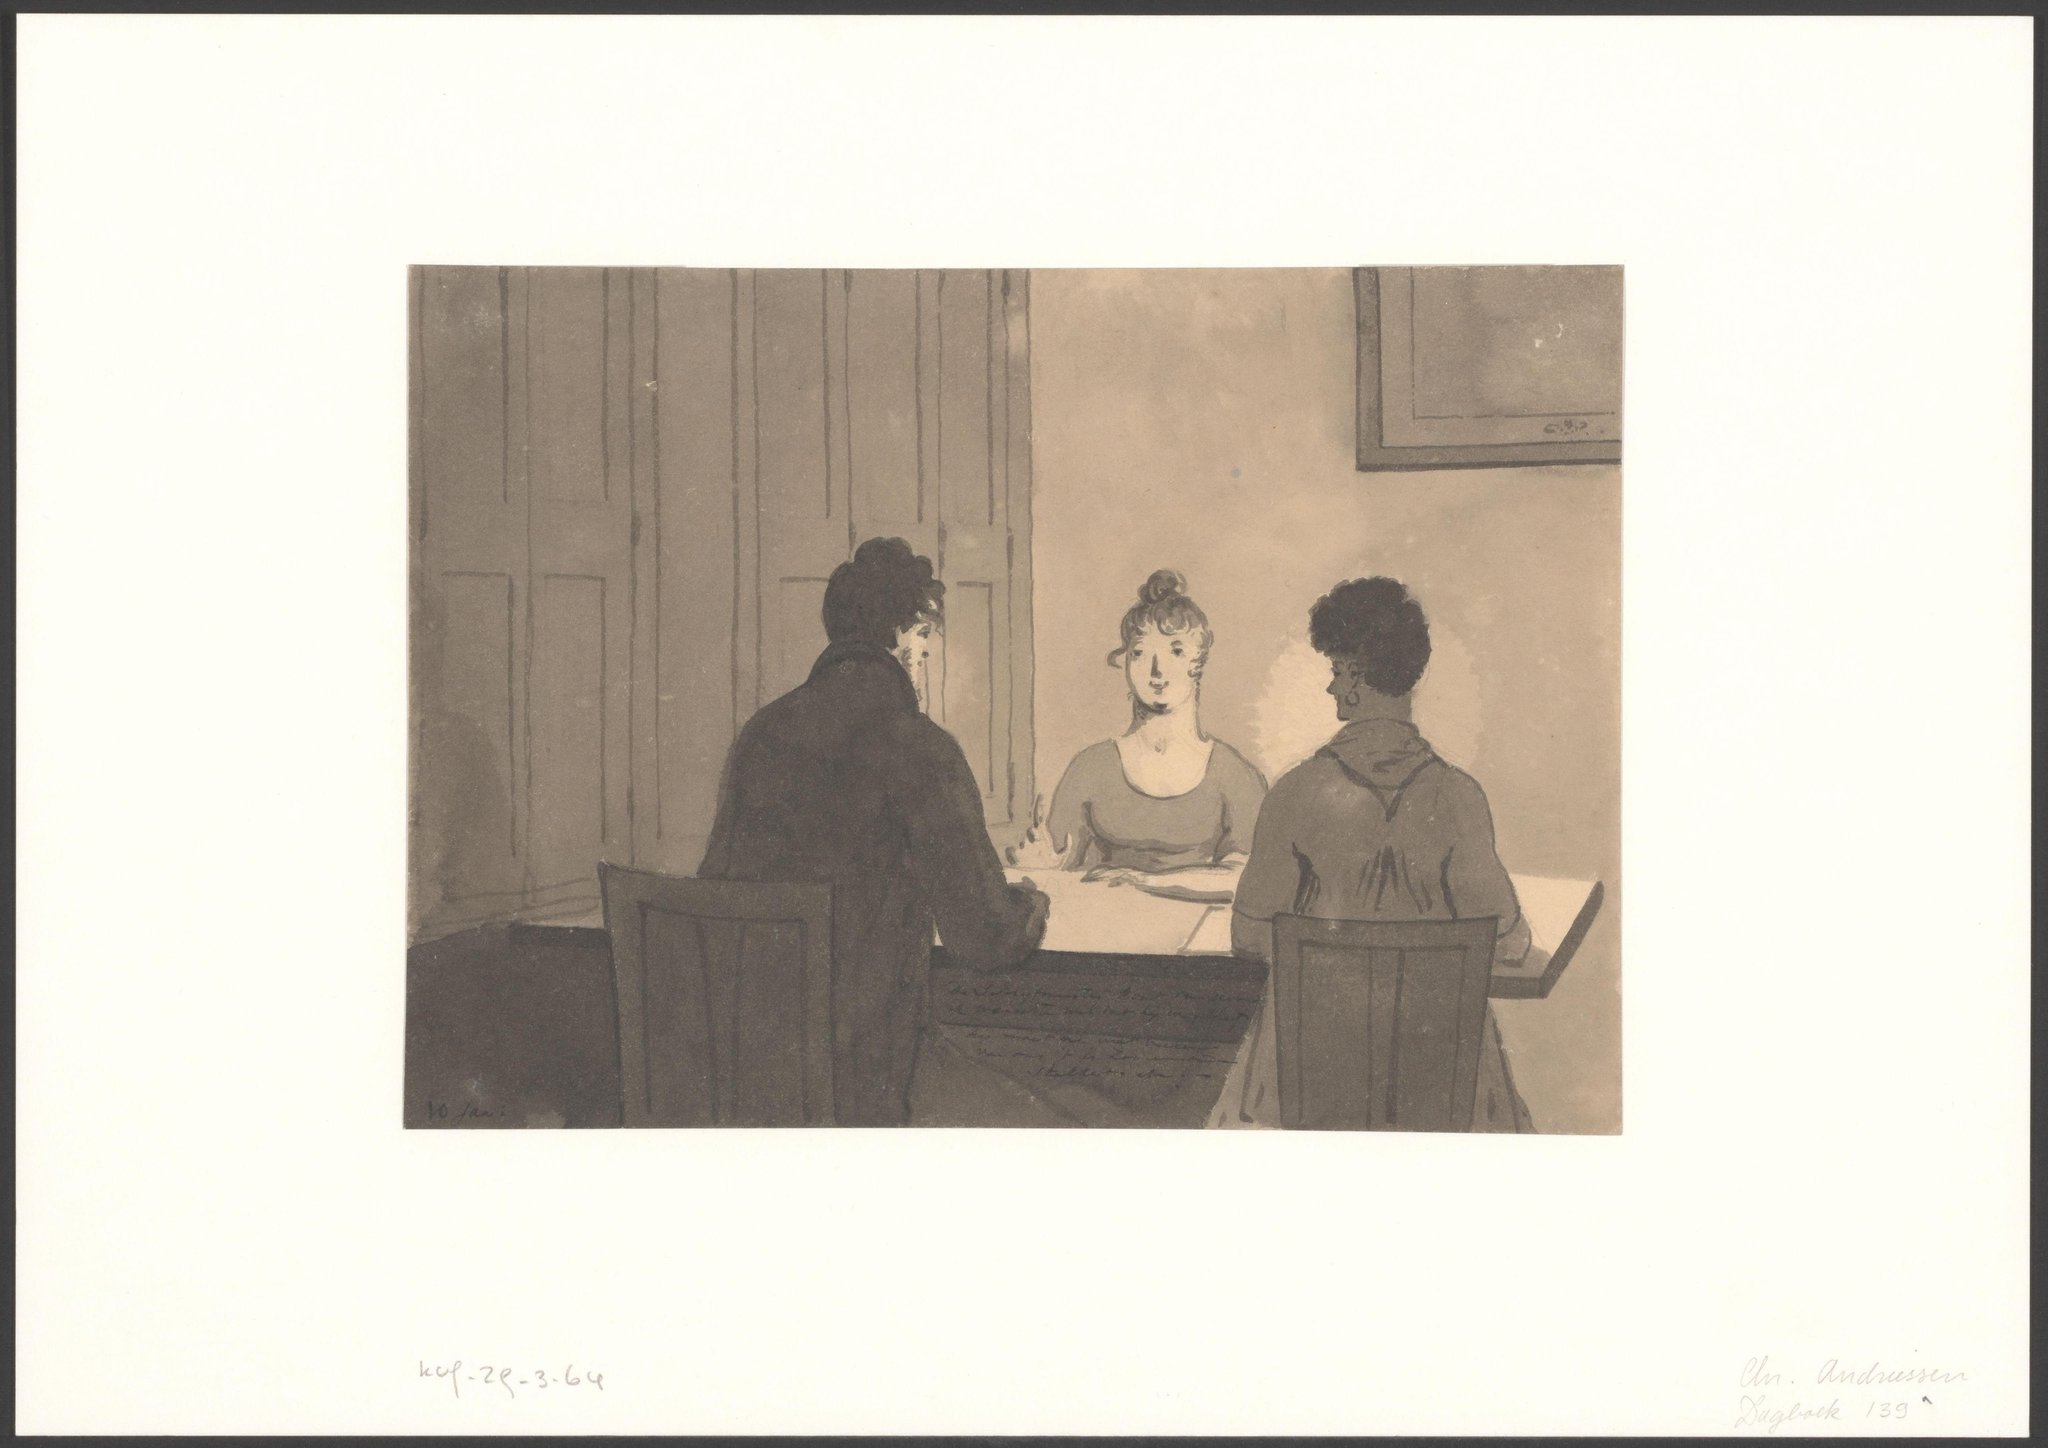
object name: drawing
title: Schrijfles in de avond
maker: christiaan andriessen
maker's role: draughtsman, print maker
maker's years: 1775-1846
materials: ink, paper, pencil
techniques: brush, pen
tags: amsterdam, print maker, draughtsman, christiaan andriessen, candle, interior of the house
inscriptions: inscription: ‘10 jan: De schrijfmeester komt van avond, ik wenschte wel dat hij weg bleef (...)’, inscription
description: Dagboekblad uit het getekende dagboek dat Christiaan Andriessen bijhield van 1805 tot en met 1808.